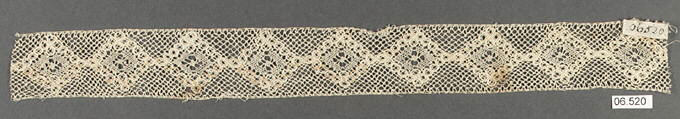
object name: fragment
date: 1801-1833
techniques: lace